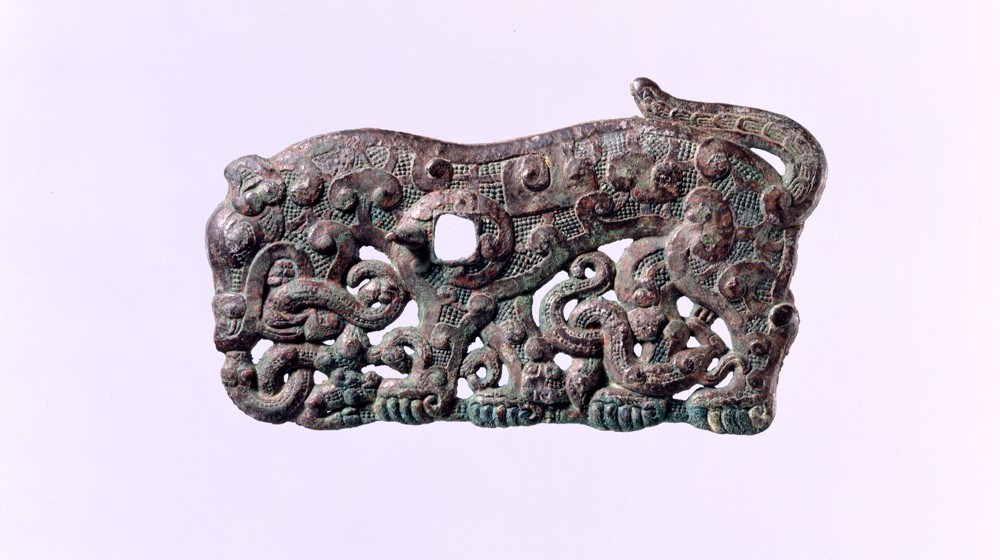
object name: belt plaque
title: Belt Plaque in the Shape of a Standing Carnivore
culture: northwest chinese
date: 400-301 BCE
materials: bronze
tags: animals